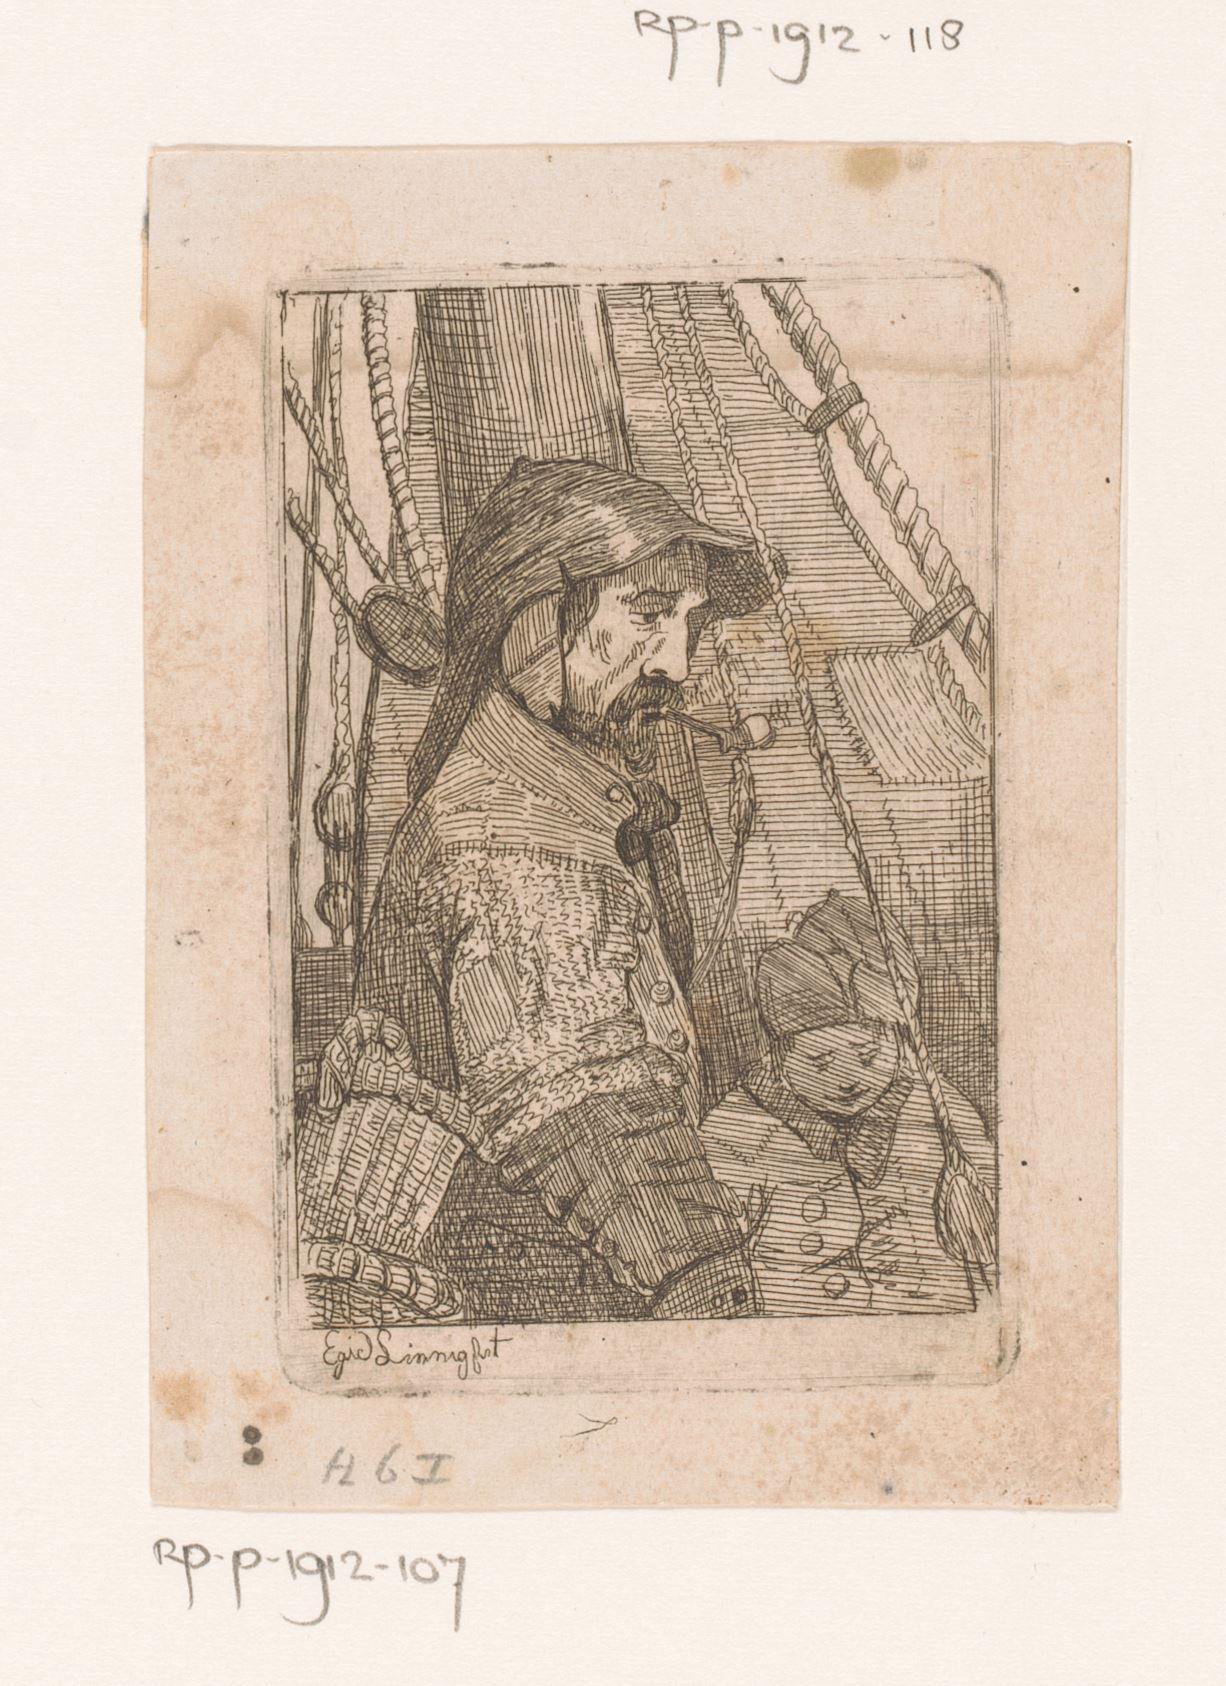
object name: print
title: Visser en een jongen aan boord van een zeilschip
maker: egidius linnig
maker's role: draughtsman, print maker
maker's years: 1821-1860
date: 1831-1860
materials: paper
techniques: etching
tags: fisherman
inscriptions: collector's mark: Lugt 1485, collector's mark: Lugt 2228